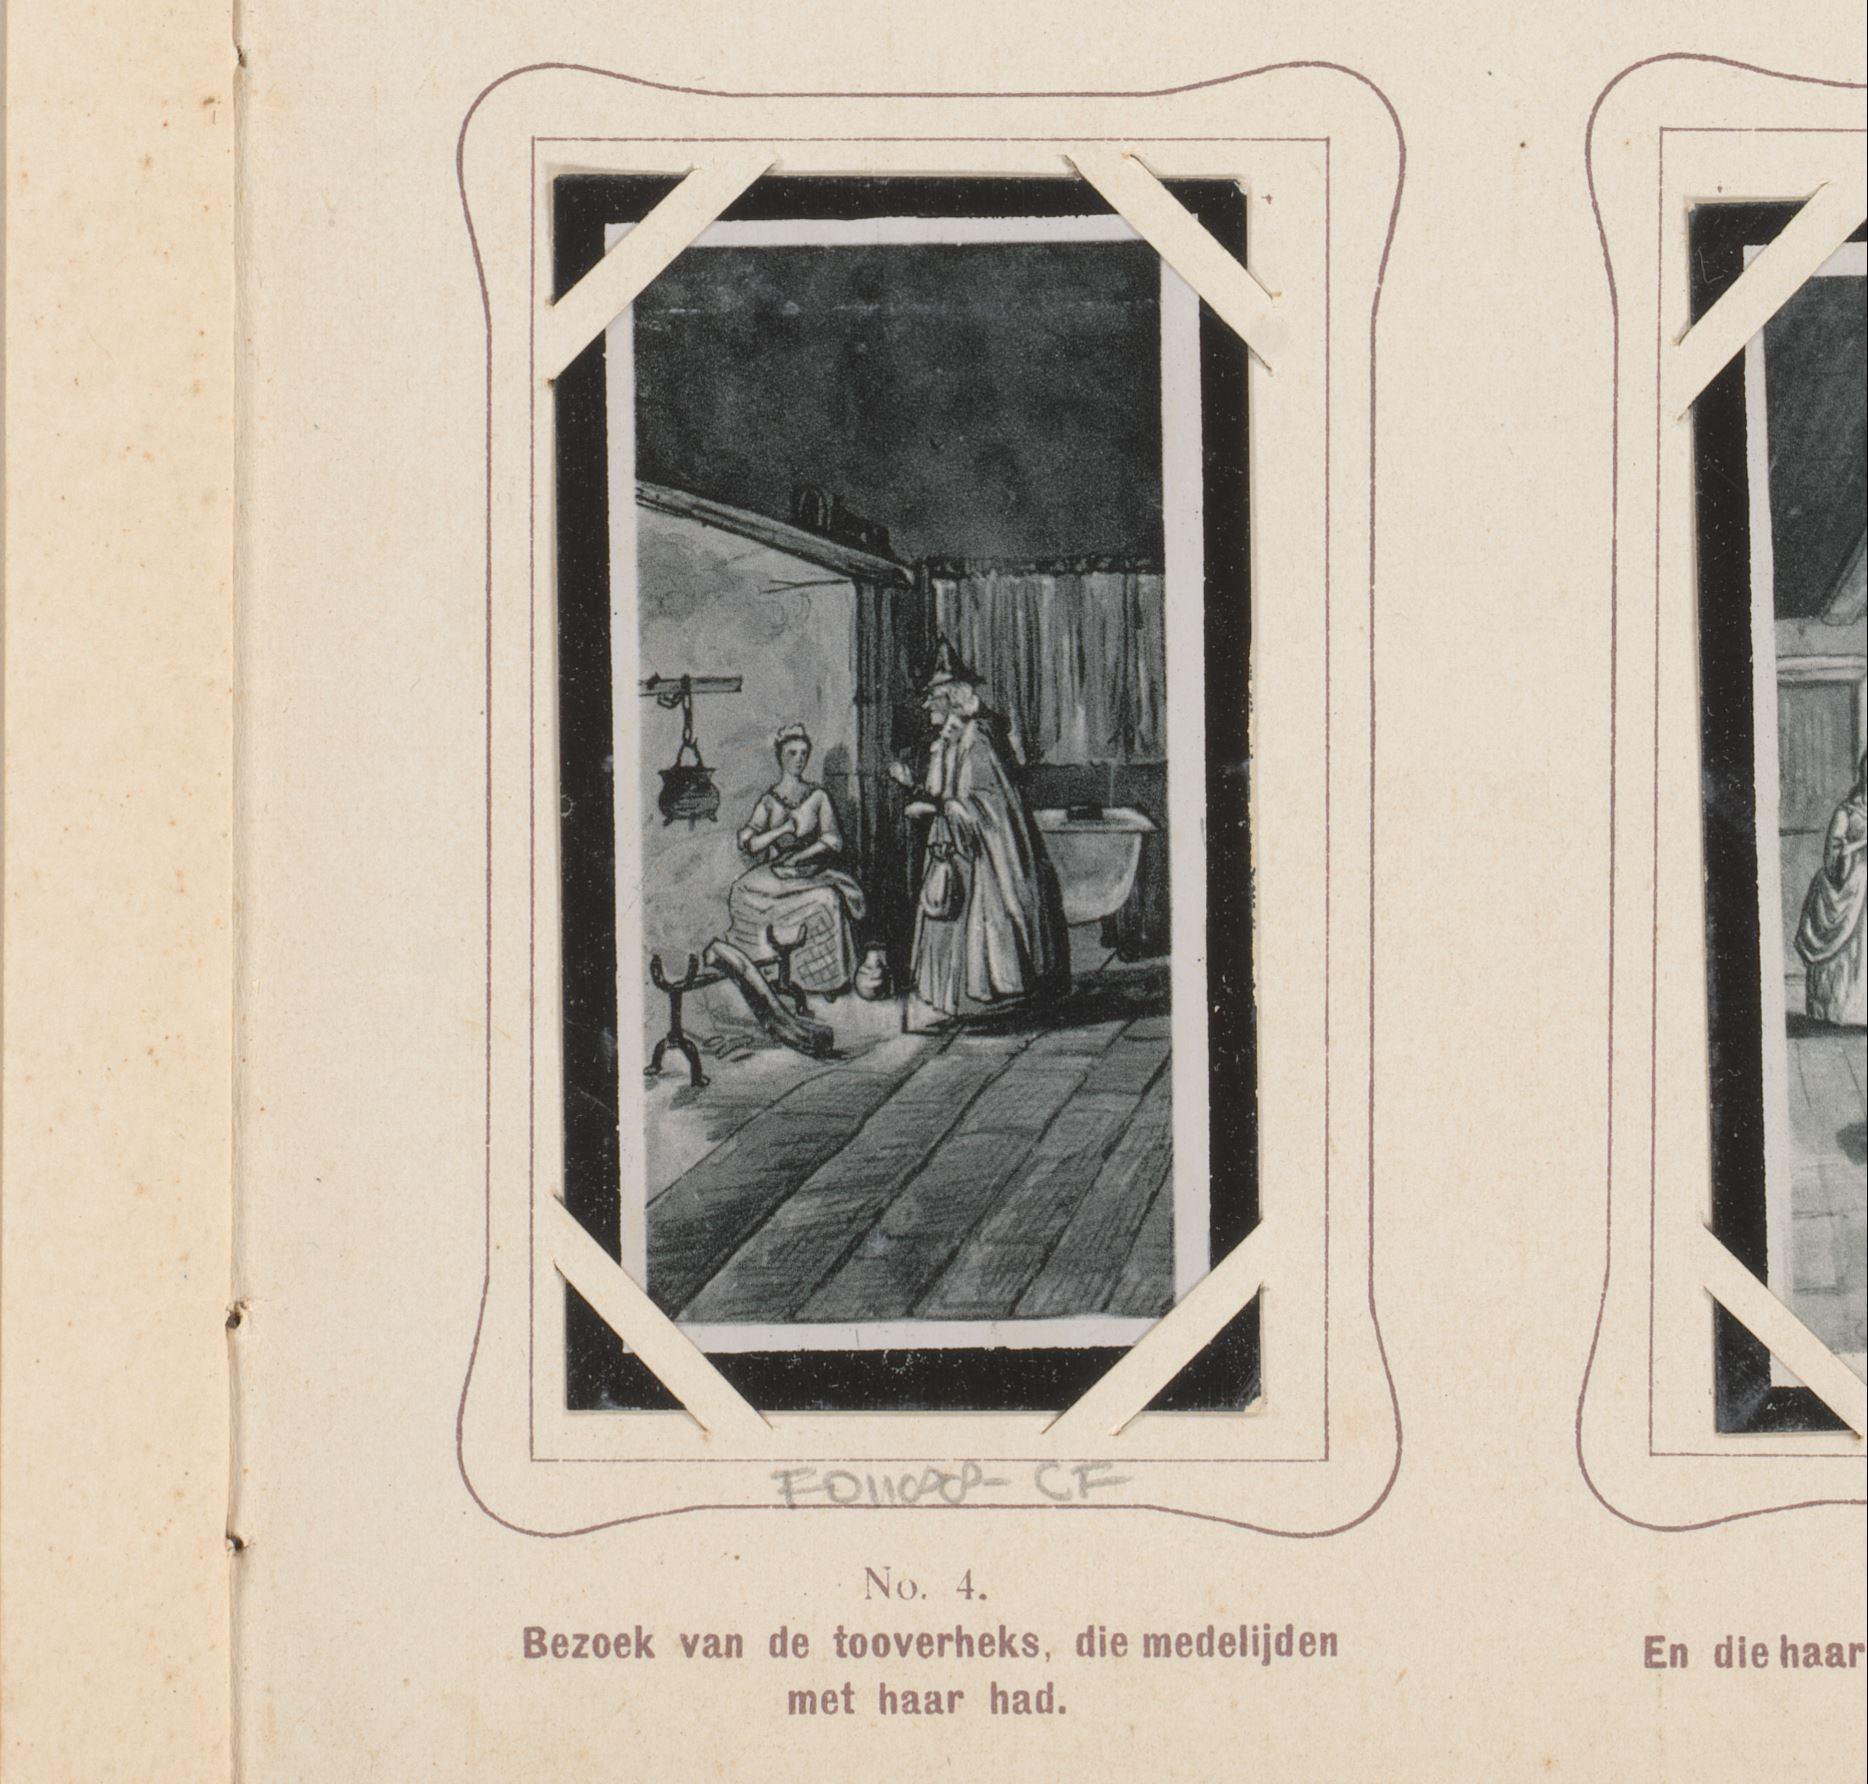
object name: photomechanical print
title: Reproductie van een tekening van het bezoek van de heks aan Assepoester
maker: Anonymous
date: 1906-1907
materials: paper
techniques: photograph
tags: tales and fairy tales (with title)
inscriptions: inscription: ‘No. 4./ Beoek van de tooverheks, die medelijden met haar had.’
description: Deze prent maakt deel uit van een album.